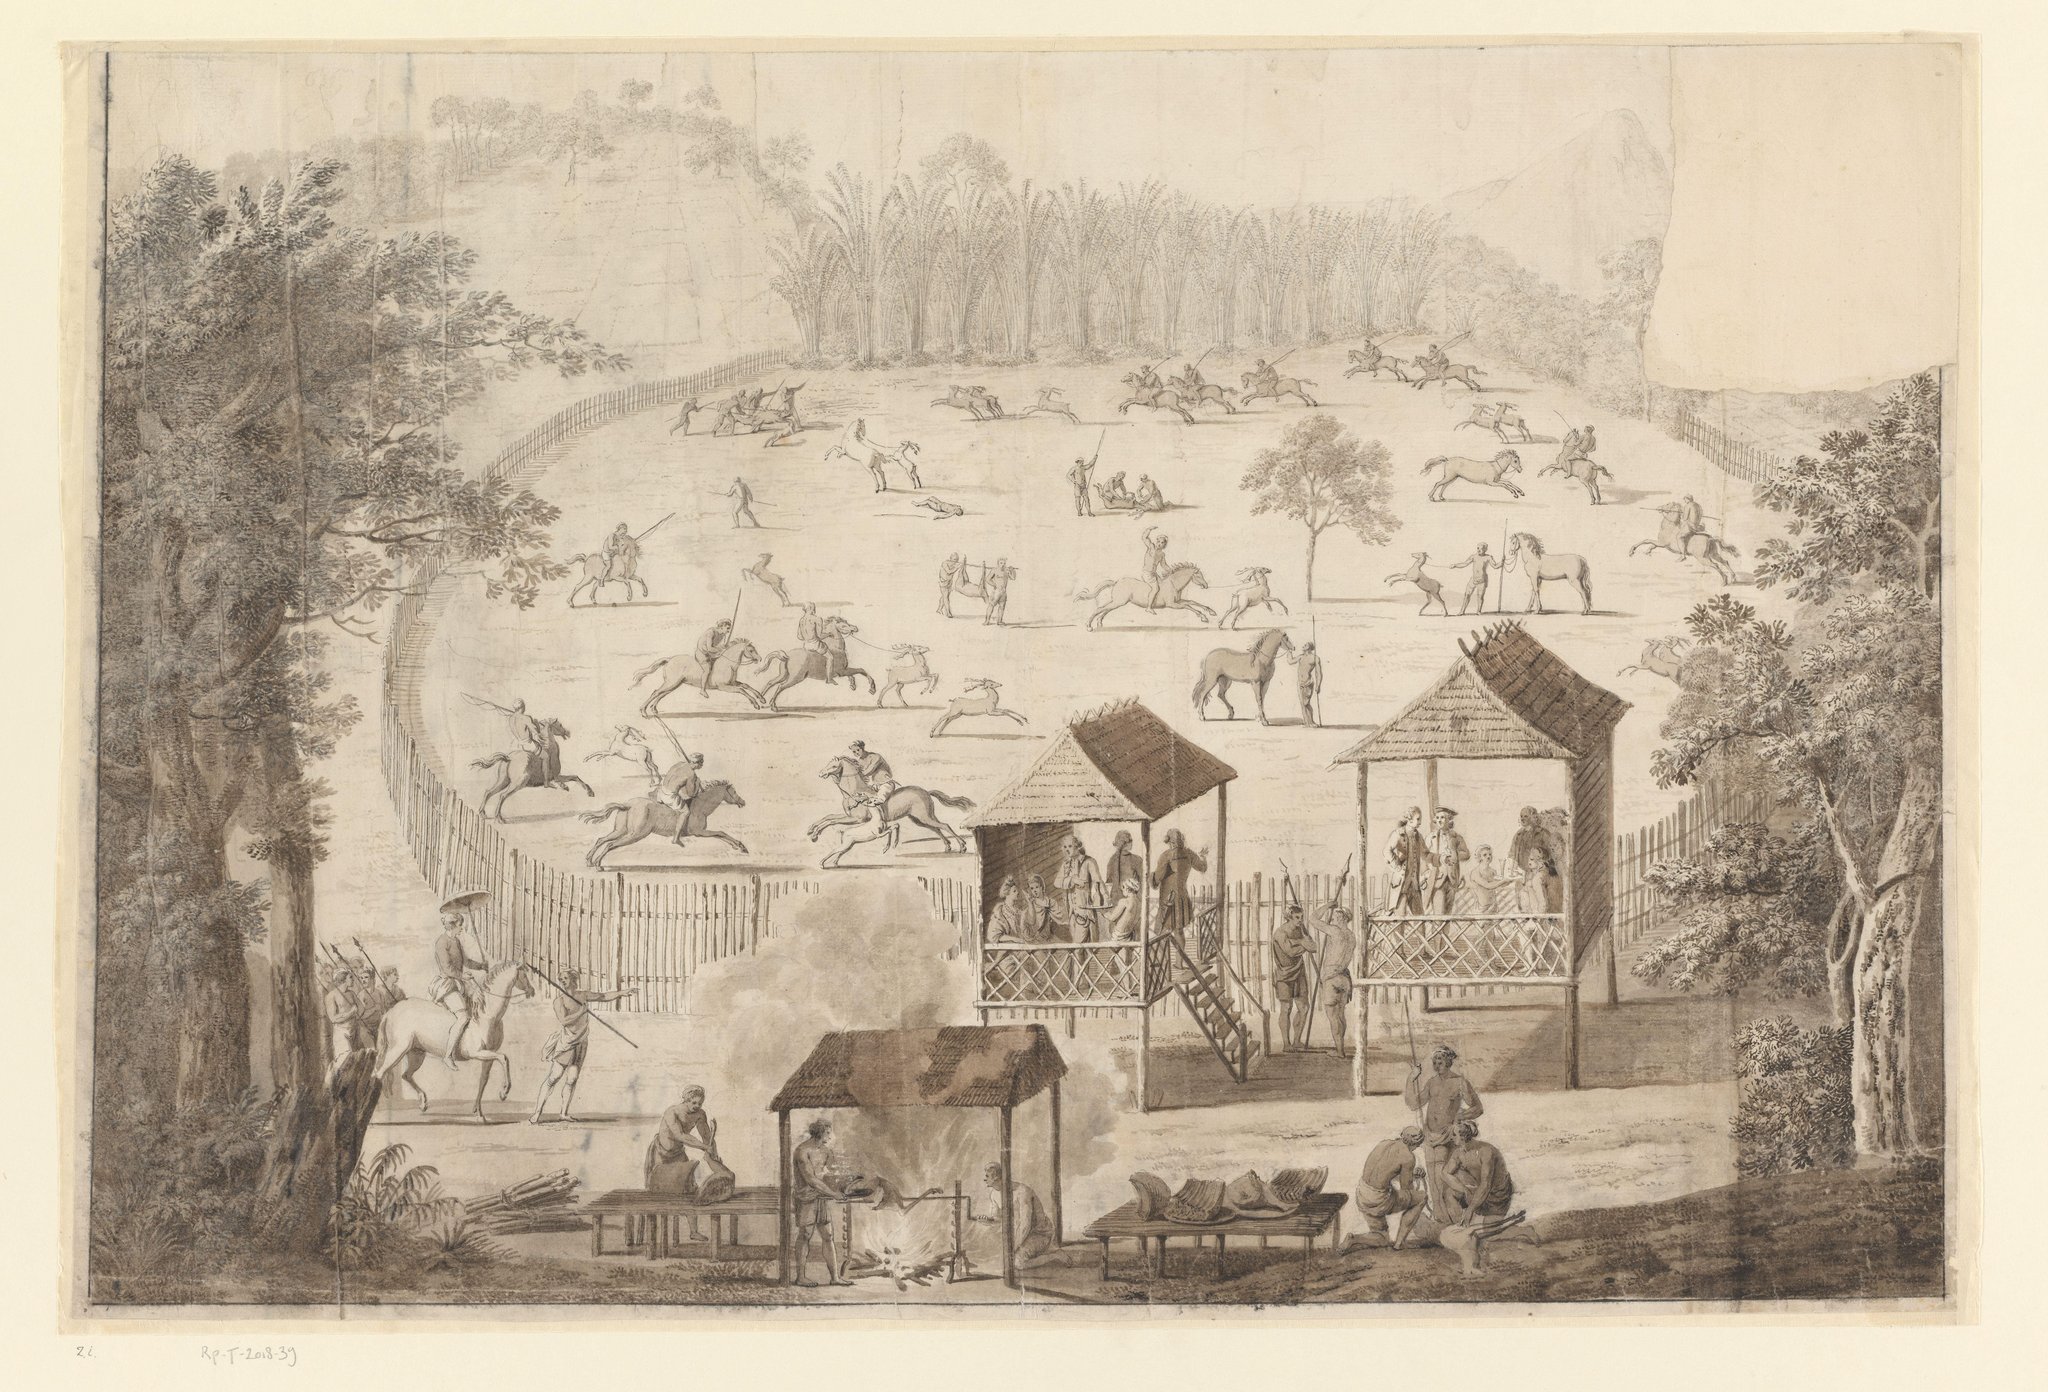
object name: drawing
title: Gezicht op een jachtpartij en het bereiden van de vangst in Nederlands Oost-Indië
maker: Anonymous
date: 1700-1799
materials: ink, paper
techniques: brush, pen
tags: butler, roasting, grilling - cc - in the open air, hunt ~ mammals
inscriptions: collector's mark: Lugt 2228